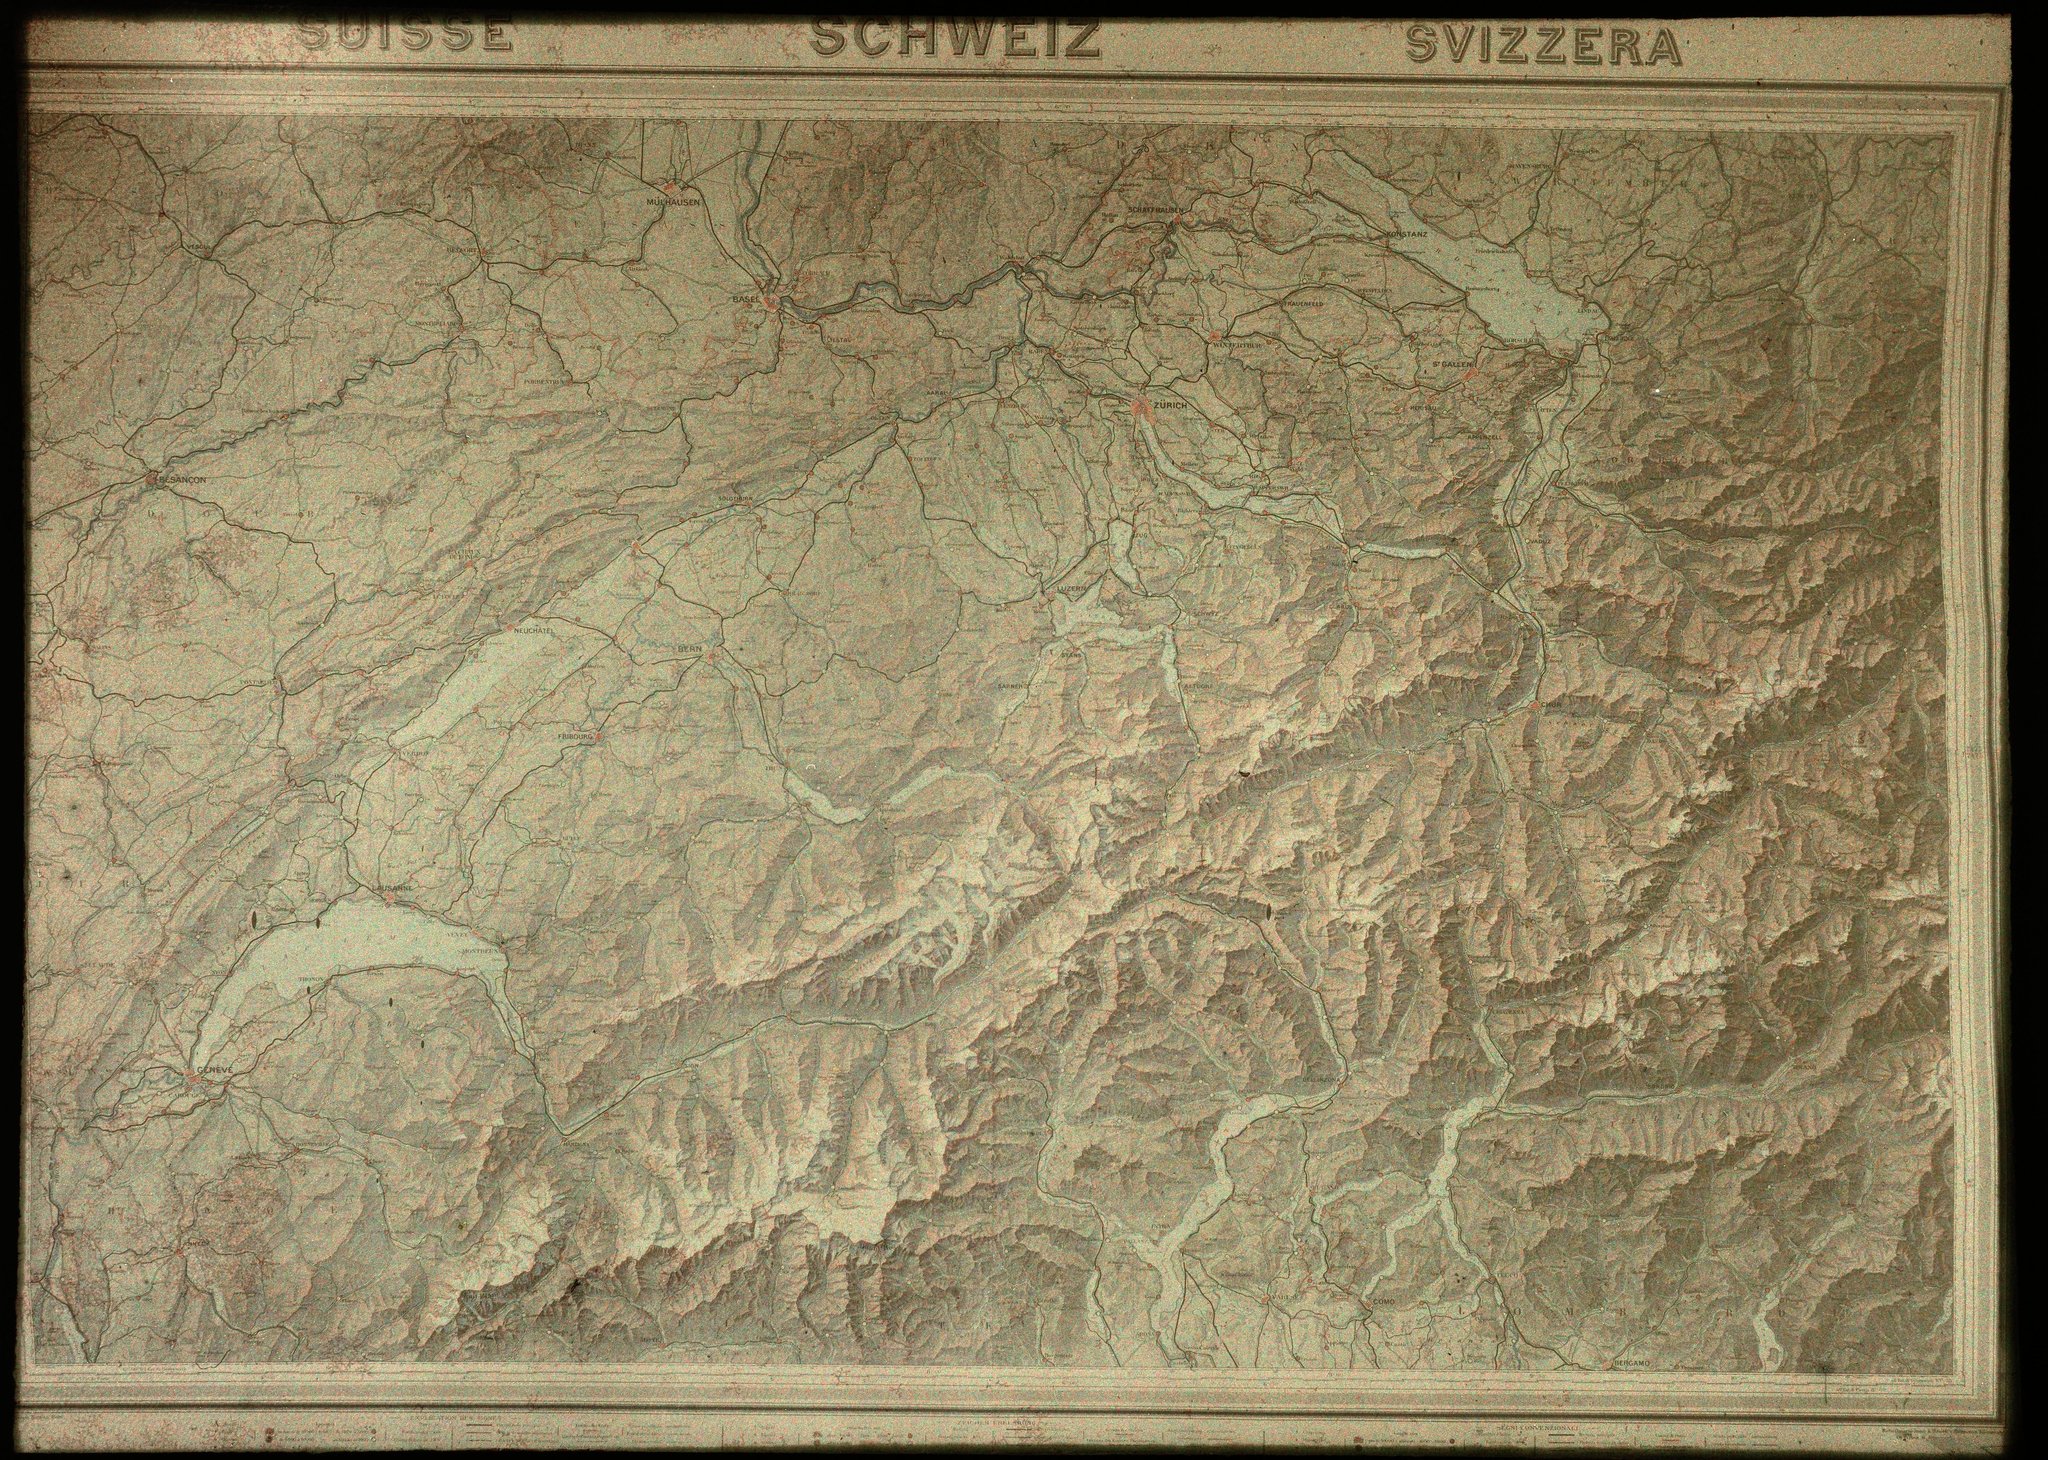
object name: color slide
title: Landkaart van Zwitserland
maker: adolphe burdet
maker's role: fotograaf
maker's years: 1860-1940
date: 1907-1930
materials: glass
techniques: autochrome process, slide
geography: netherlands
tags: switzerland